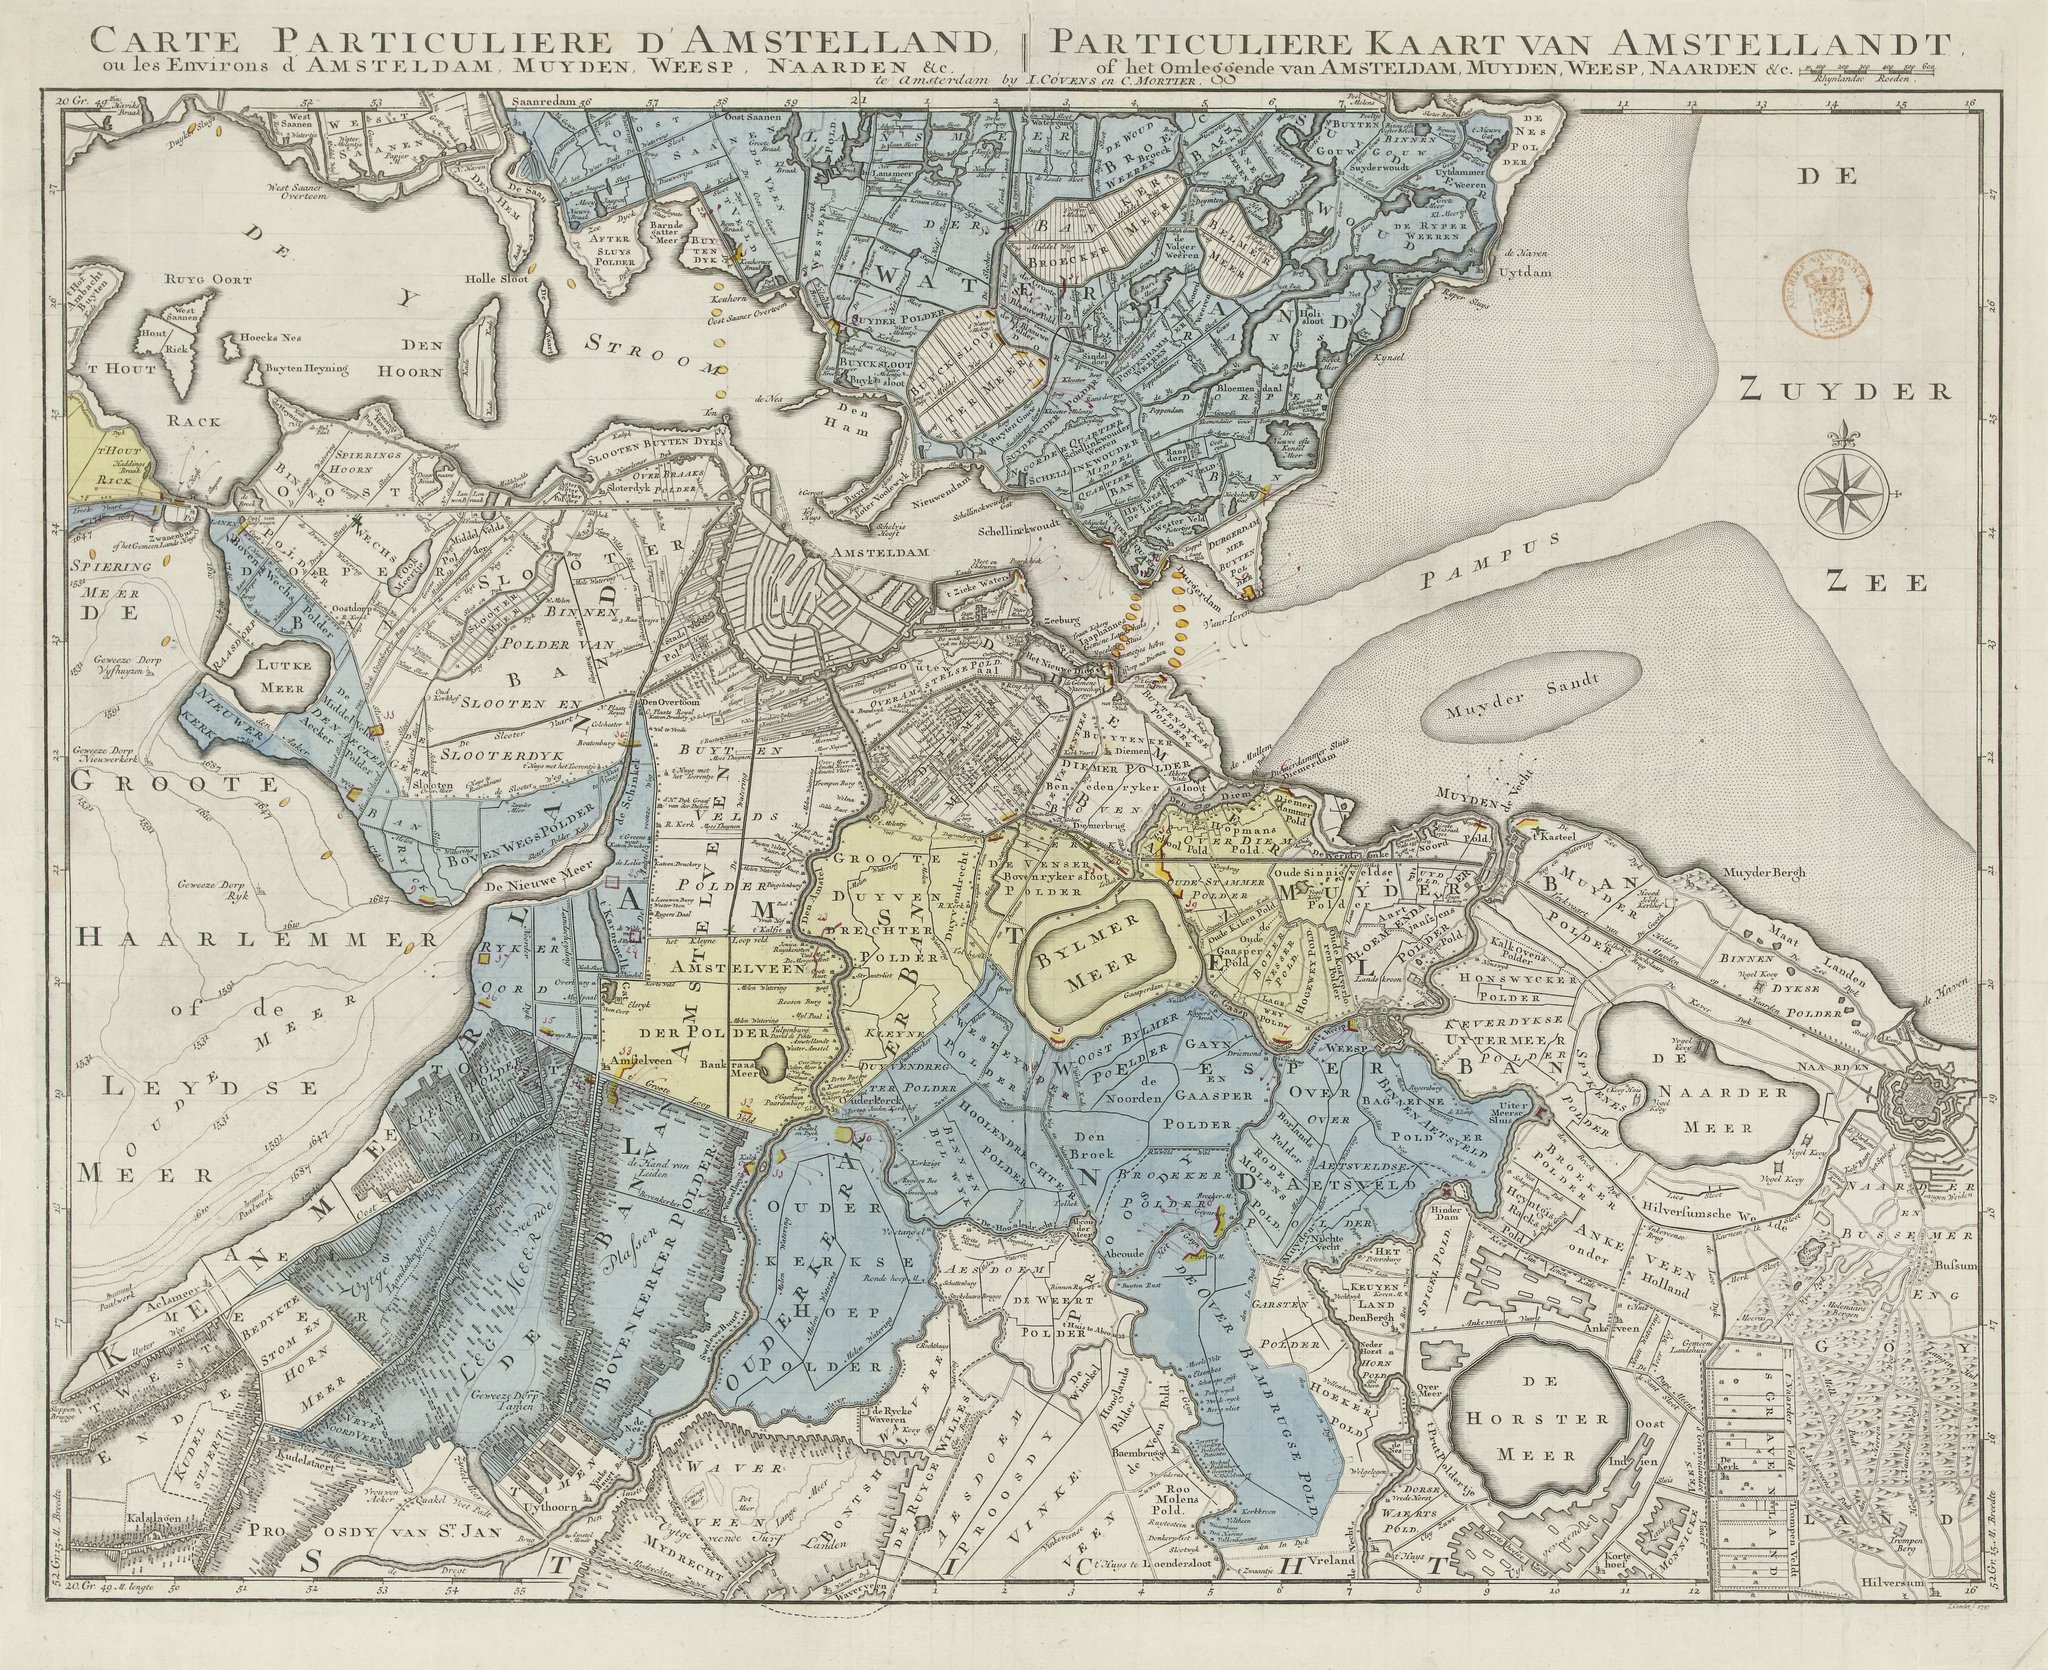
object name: map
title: Kaart van Amsterdam en omgeving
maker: johannes condet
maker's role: print maker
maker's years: 1711-1781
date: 1740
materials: paper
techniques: brush, etching, hand coloring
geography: amsterdam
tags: maps of cities, amsterdam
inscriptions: inscription: ‘1e directe situatie No. 128’, collector's mark: Lugt 19